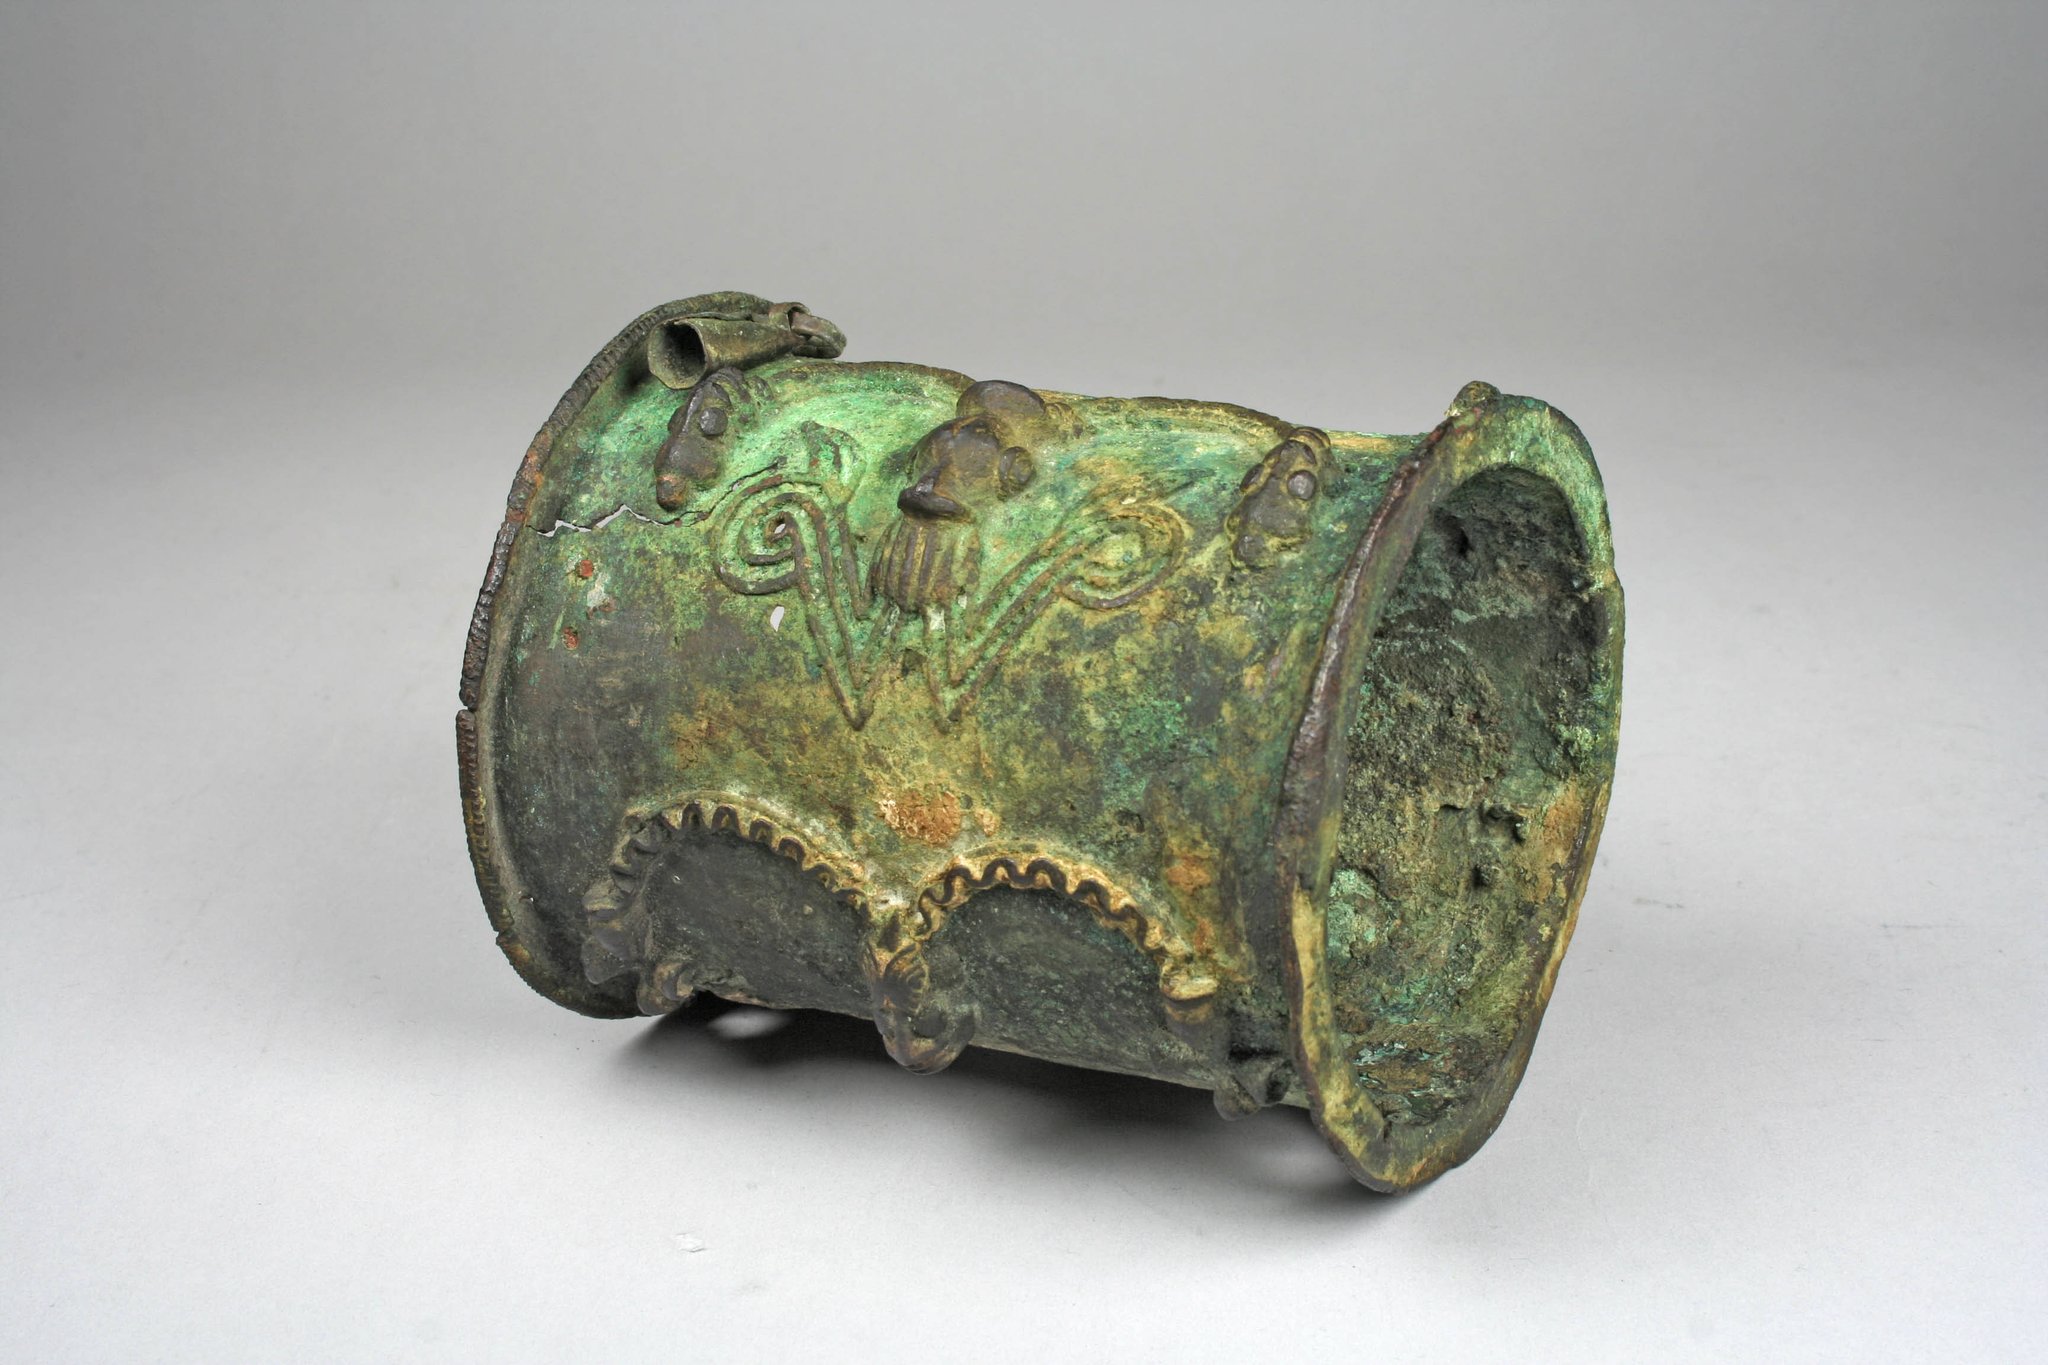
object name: bracelet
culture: yoruba peoples, ijebu group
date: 1701-1800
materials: brass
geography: nigeria